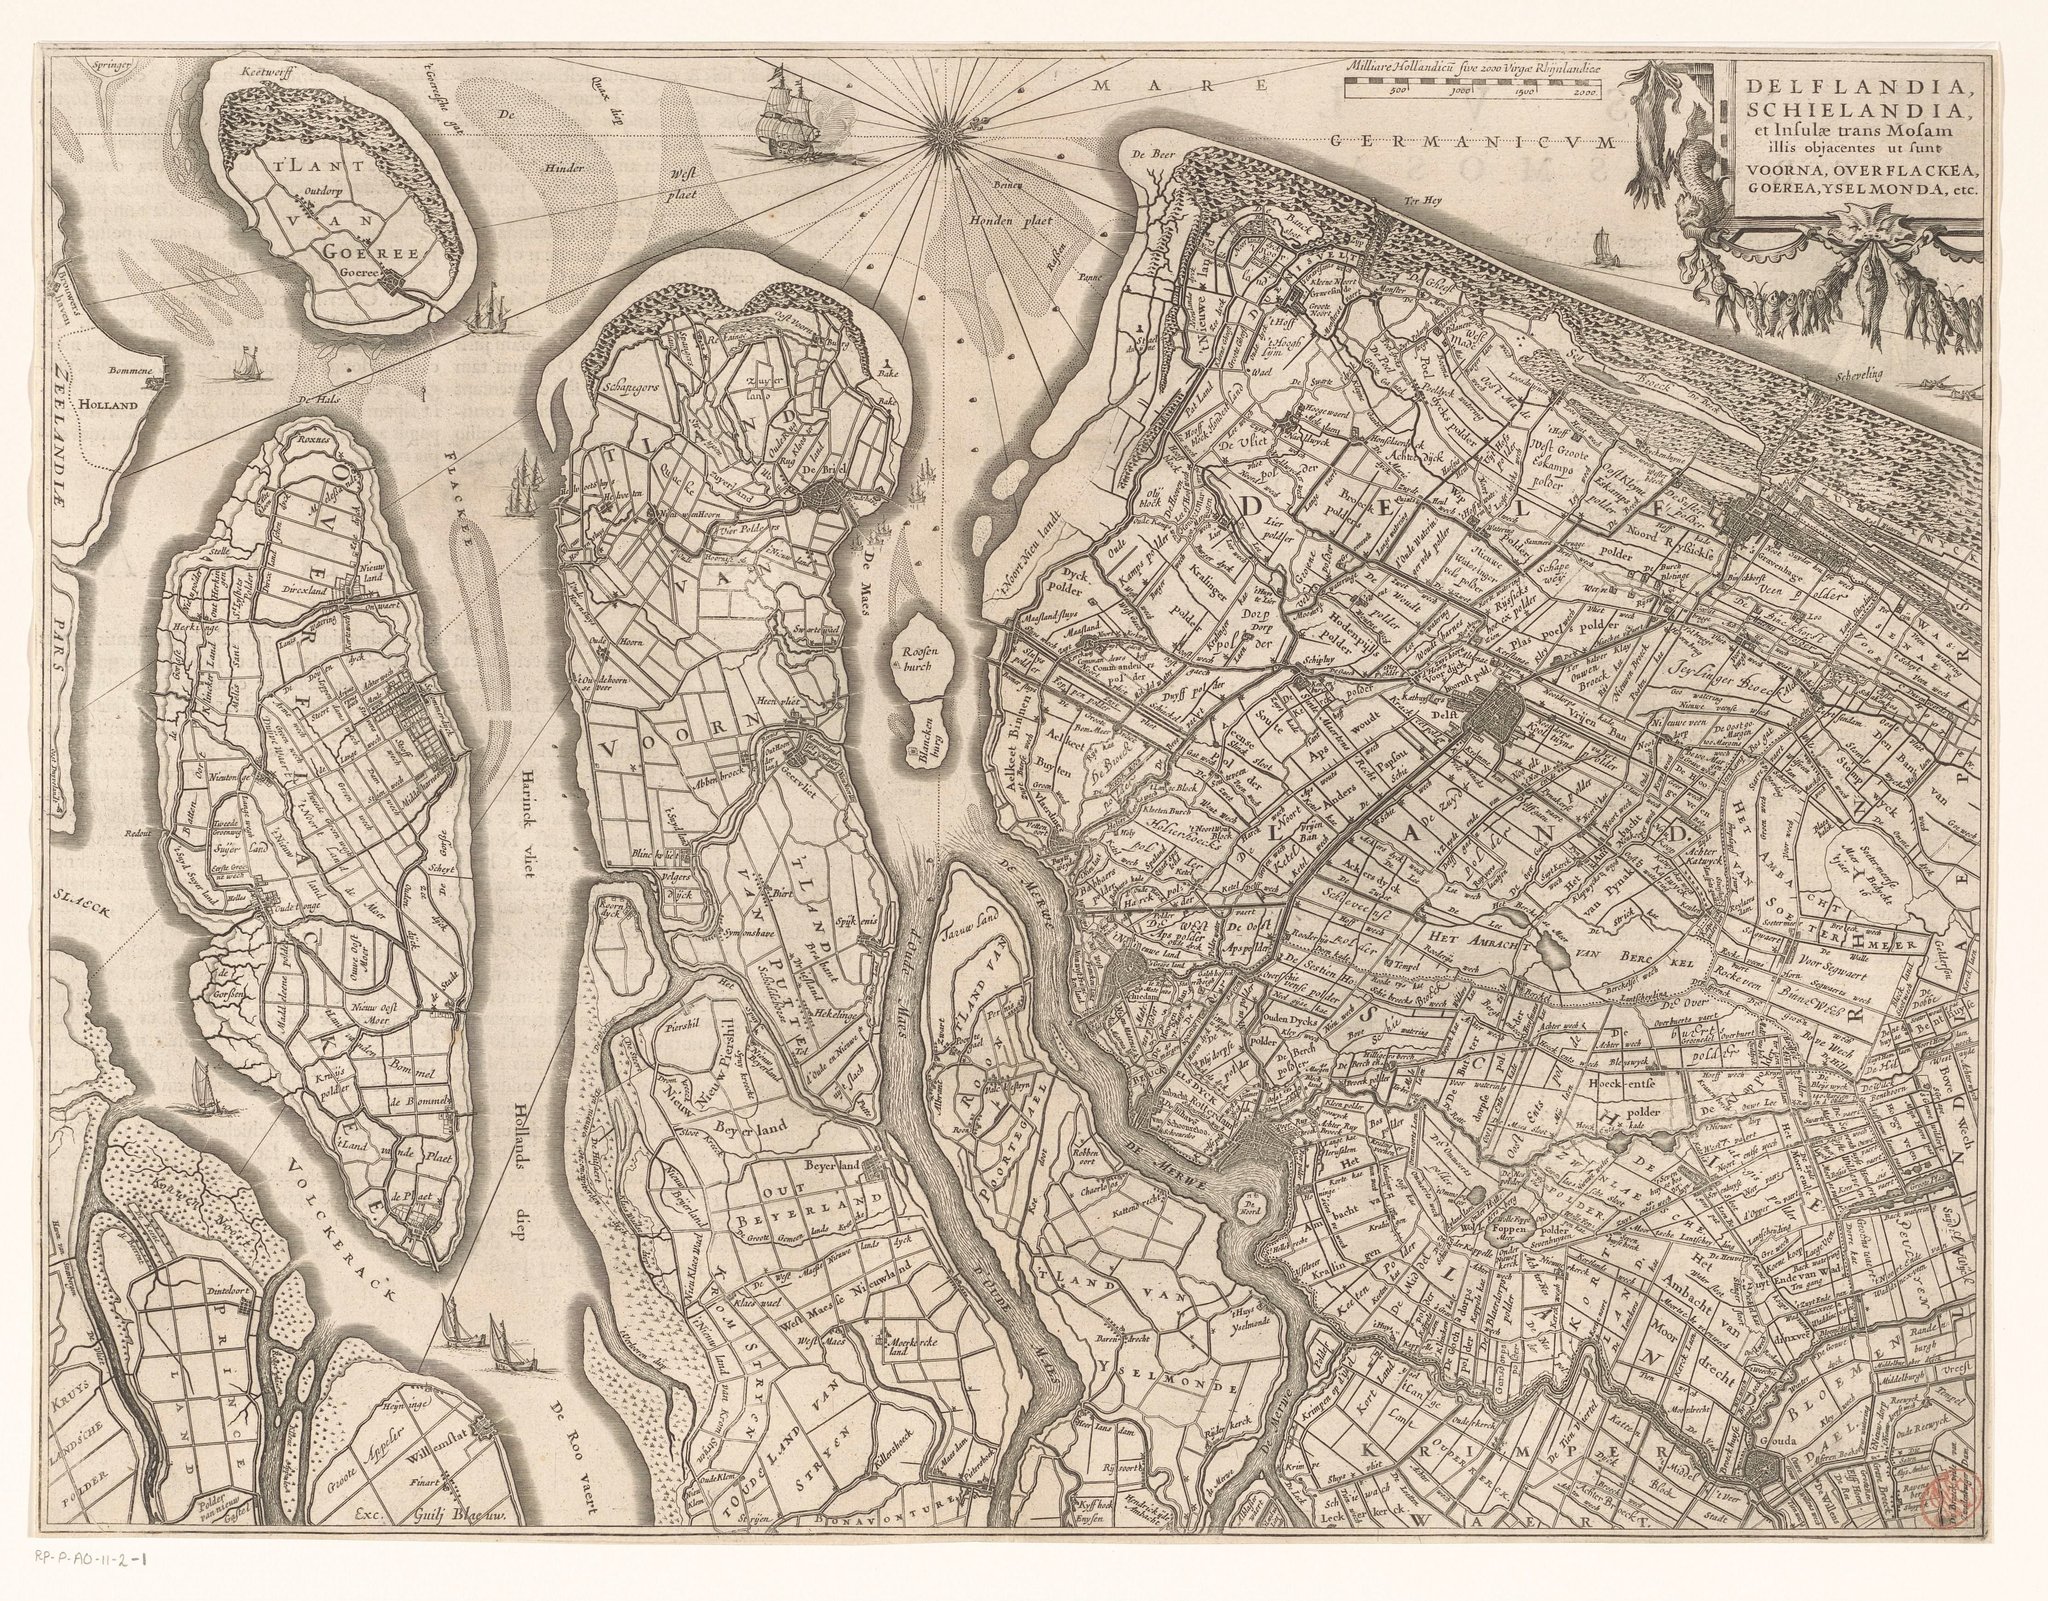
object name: map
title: Kaart van Delfland, Schieland en de Zuid-Hollandse eilanden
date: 1631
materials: paper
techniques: engraving, etching, letterpress printing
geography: amsterdam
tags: maps of separate countries or regions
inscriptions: collector's mark: Lugt 195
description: Kaart van Delfland, Schieland en de Zuid-Hollandse eilanden (onder andere Voorne, Overflakkee, Goeree en IJsselmonde). Rechtsboven de titelcartouche. Links daarvan een schaalstok: Milliare Hollandicu[m] sive 2000 virgae Rhijnlandicae. Oriëntatie: noorden rechts. Op verso Latijnse tekst.